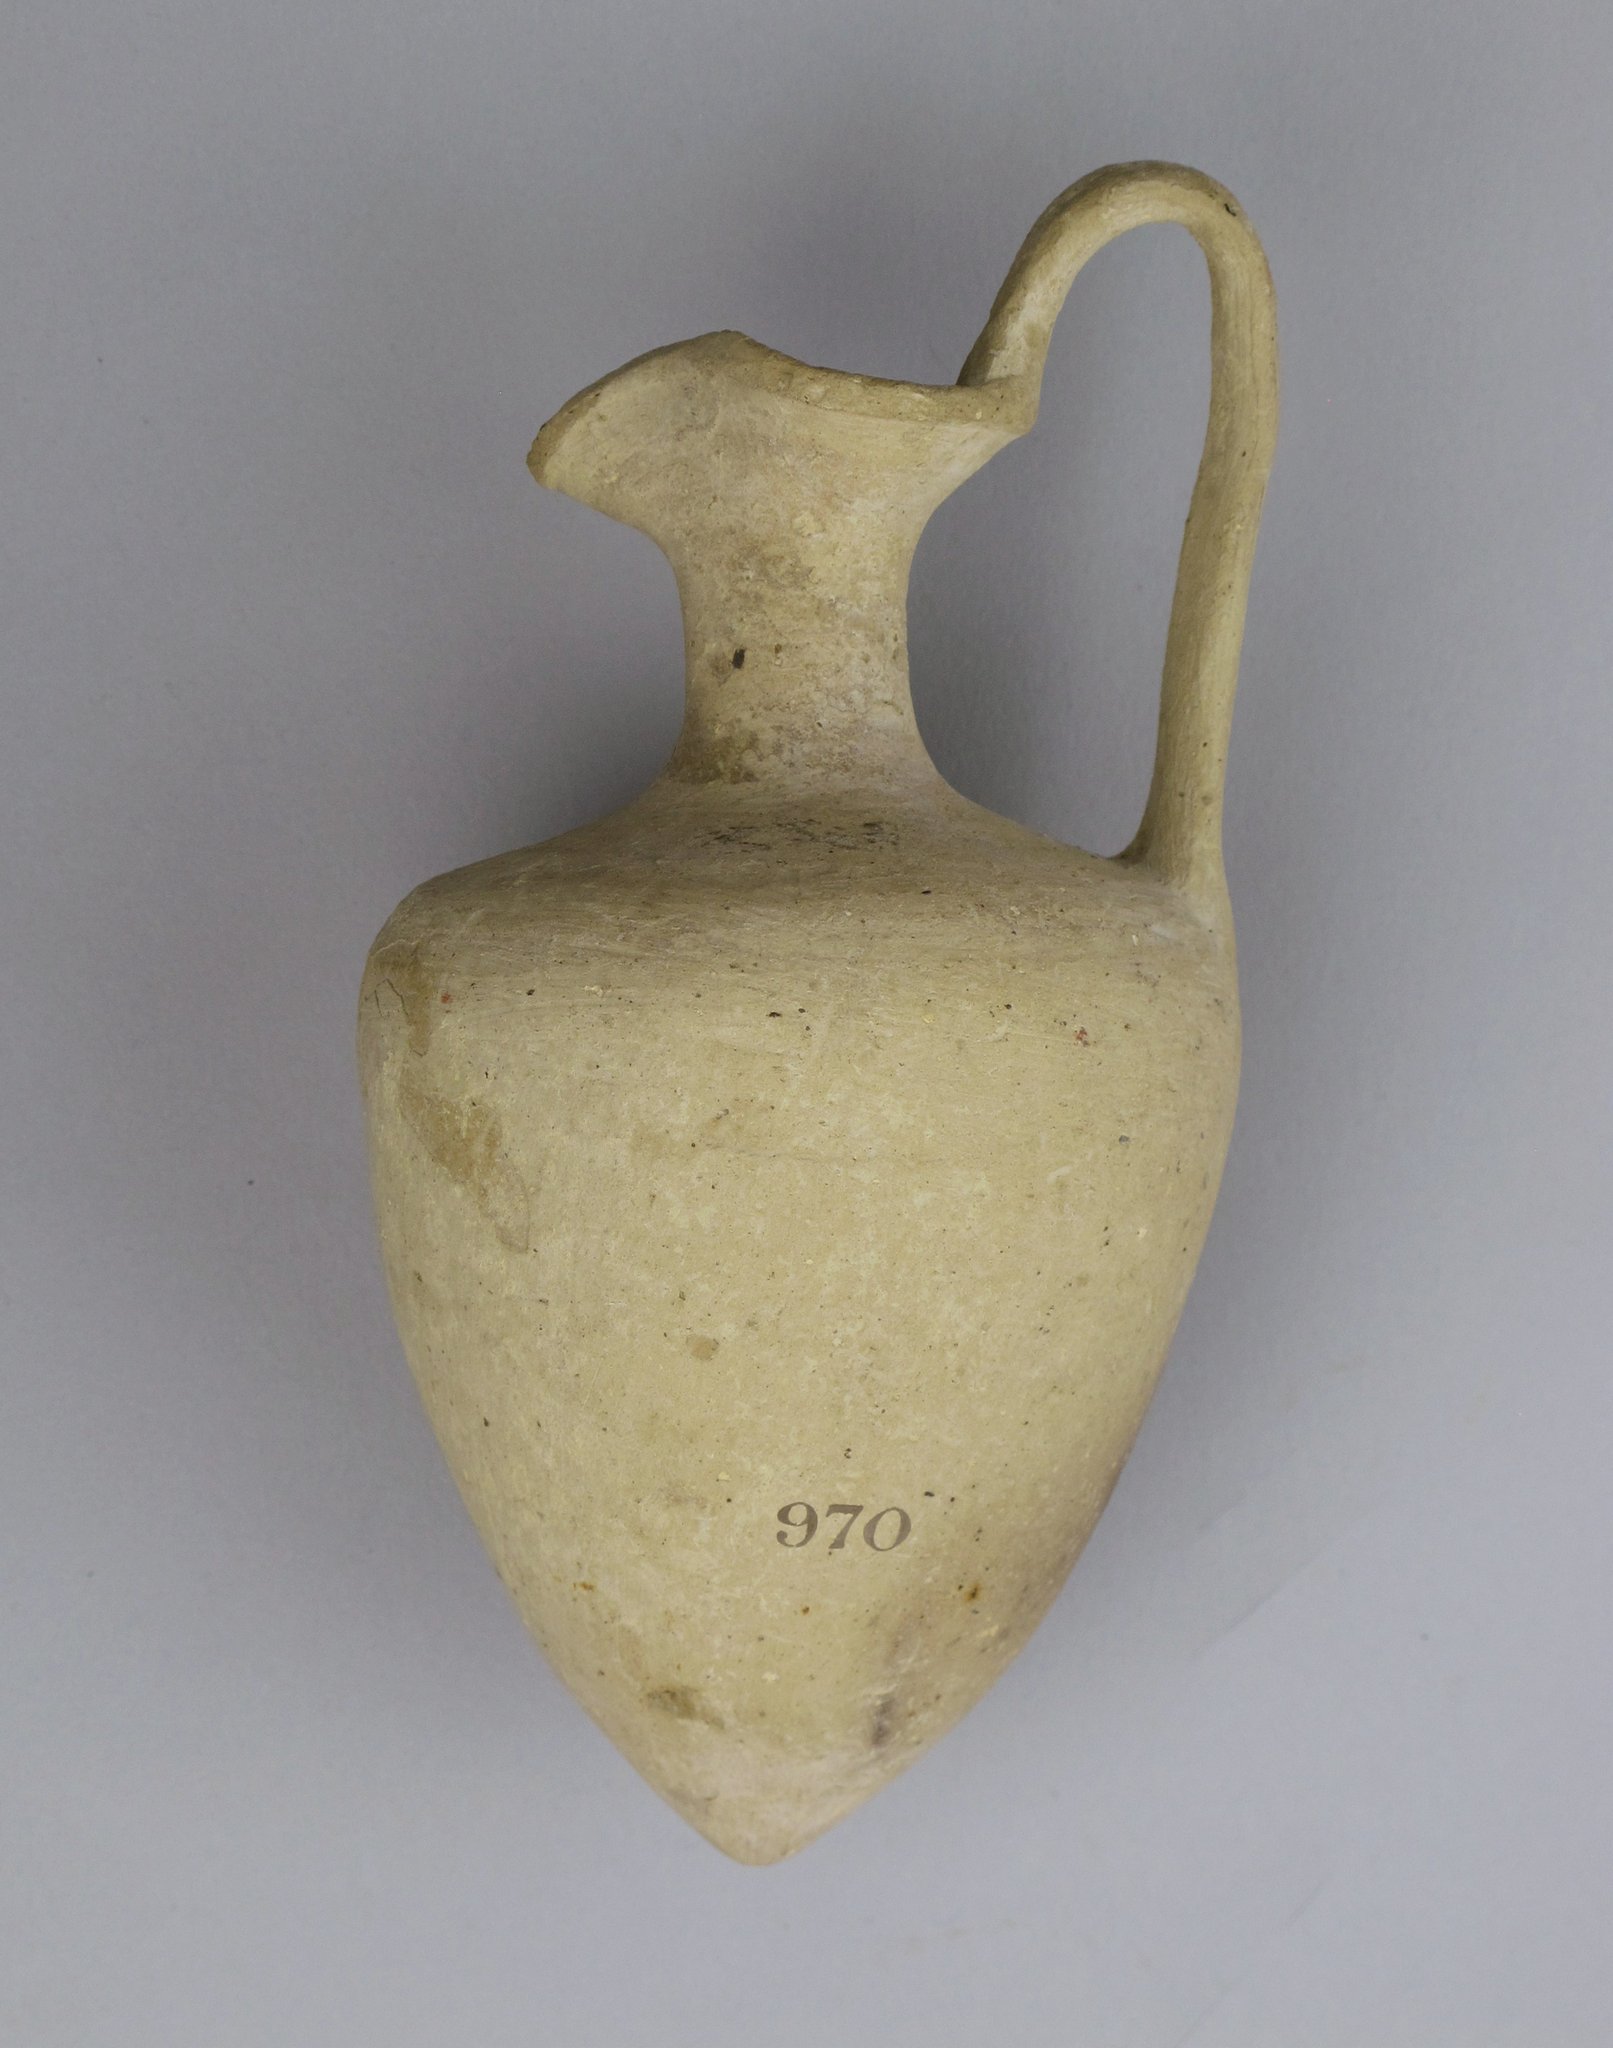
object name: juglet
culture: cypriot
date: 480-400 BCE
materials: terracotta